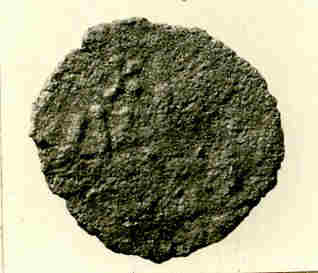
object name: coin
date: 1001-1100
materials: silver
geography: iran